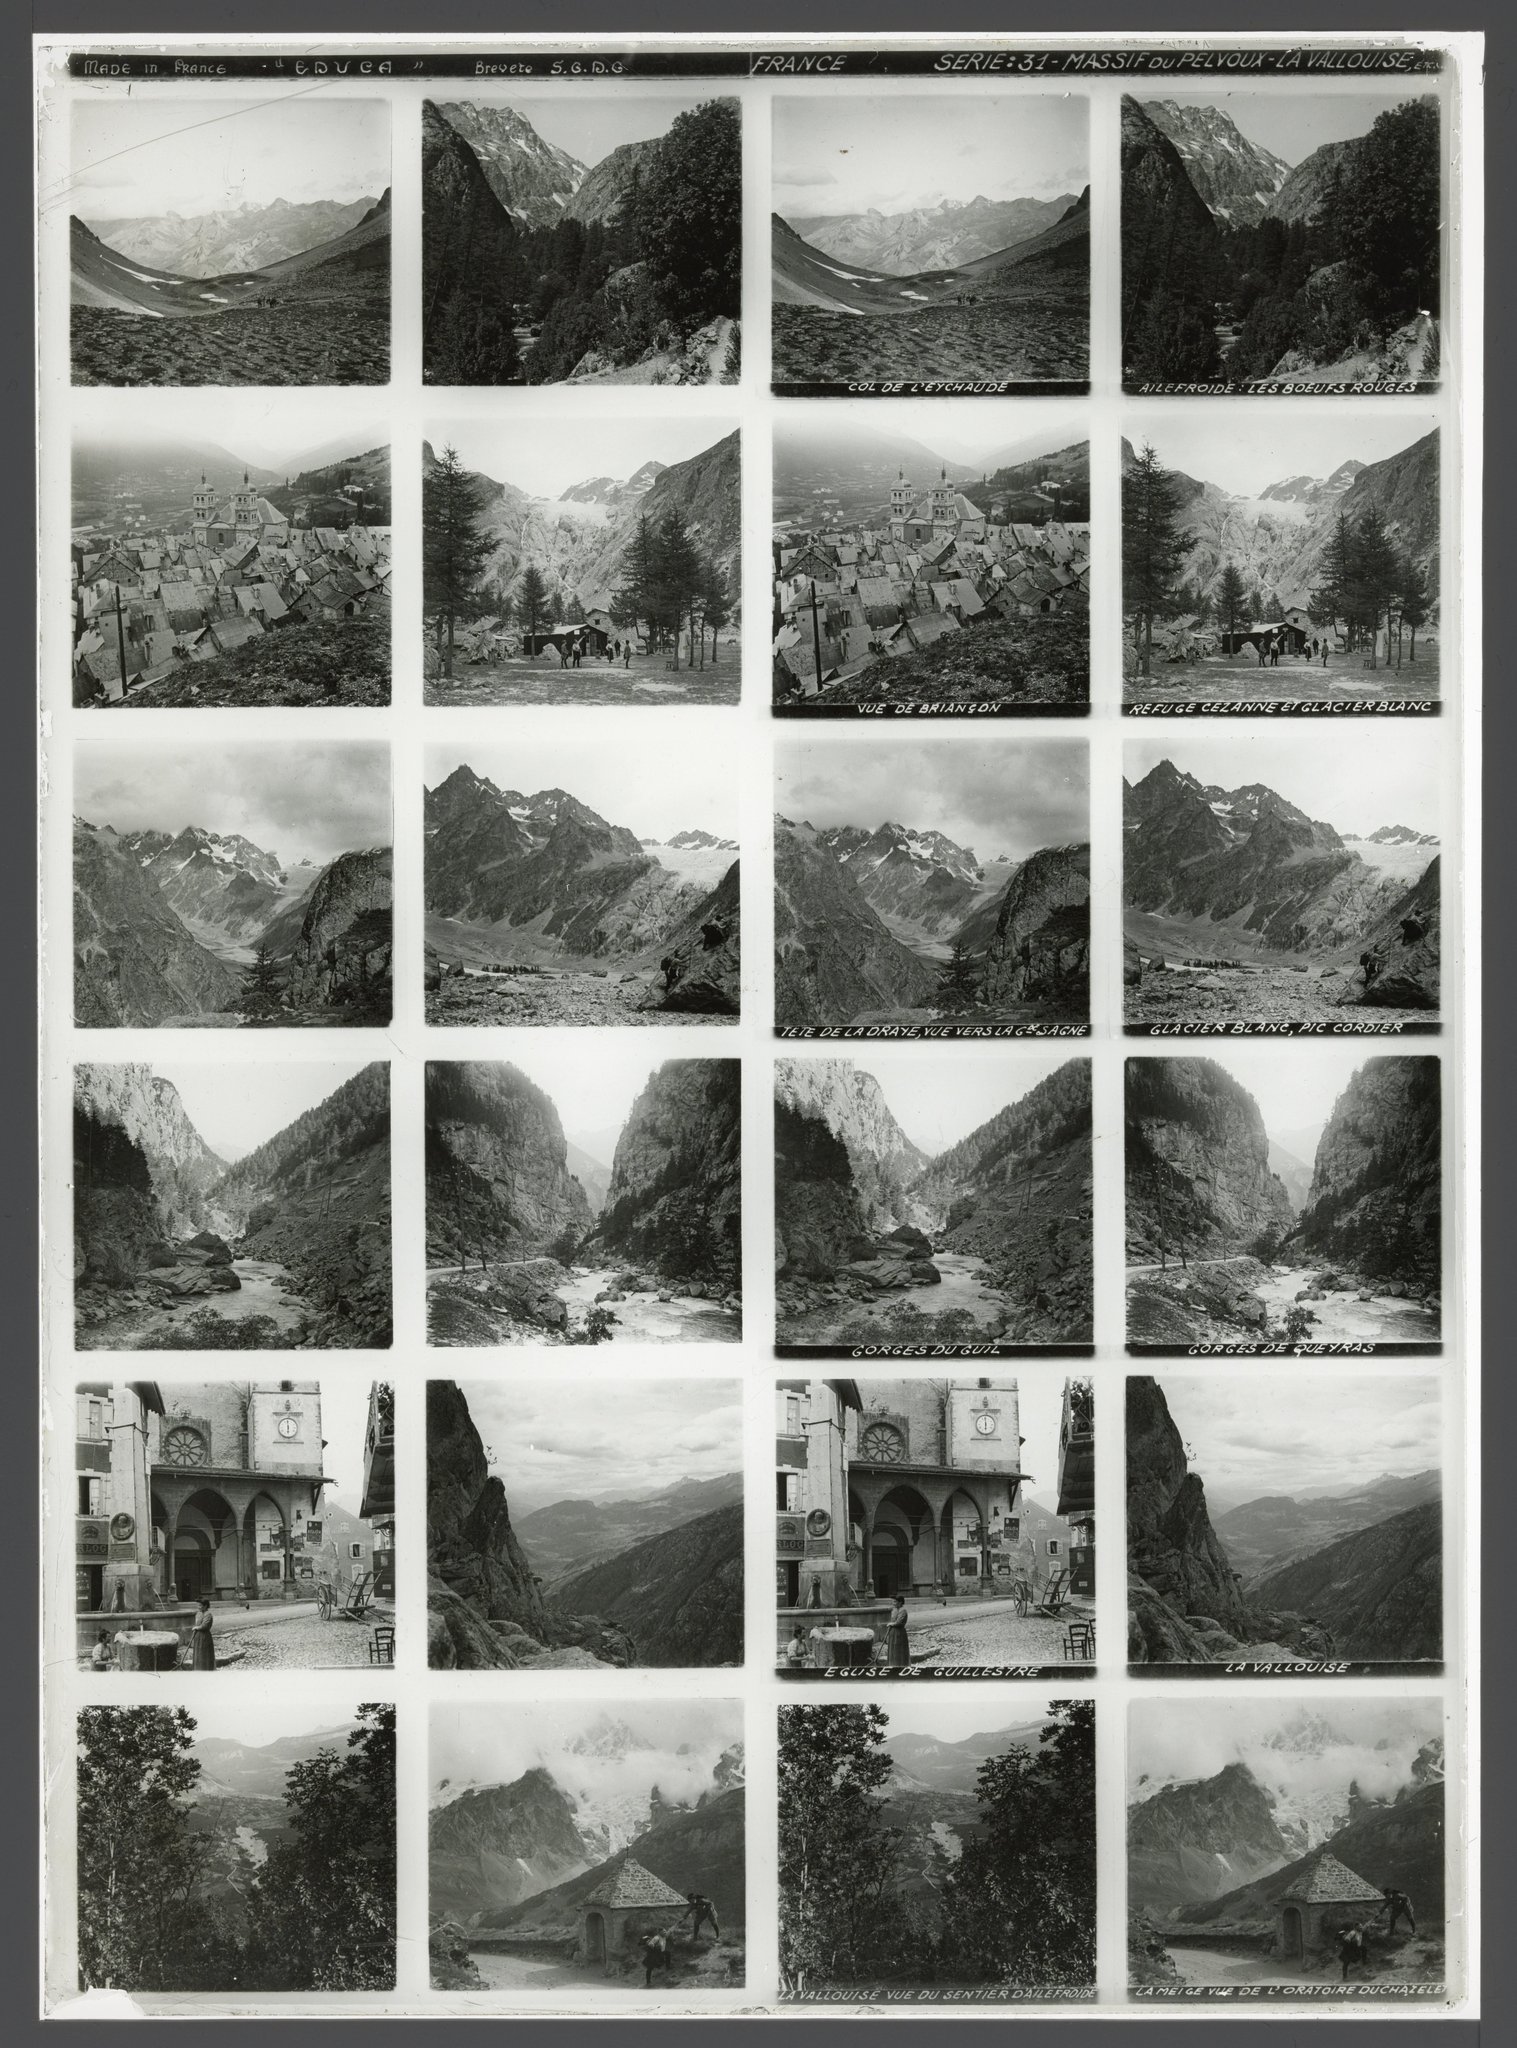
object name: stereoscopic photograph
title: France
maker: Anonymous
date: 1920-1925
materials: glass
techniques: gelatin silver transparency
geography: alps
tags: prospect of village, silhouette of village, mountains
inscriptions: inscription: ‘Made in France (...) Brevete S.G.D.G. (...)’